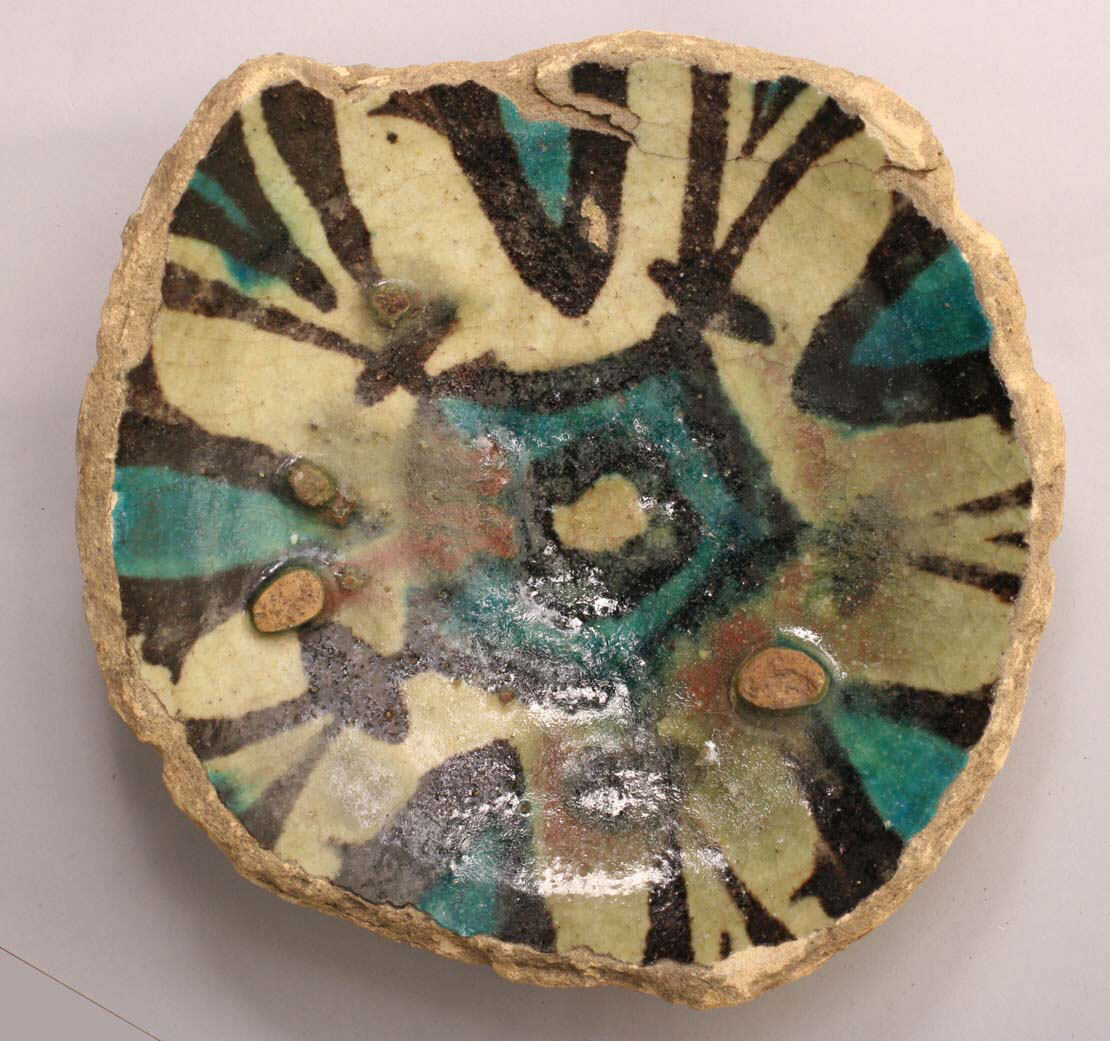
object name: fragment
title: Fragment of a Bowl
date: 1401-1500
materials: glaze, stonepaste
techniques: underglaze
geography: egypt